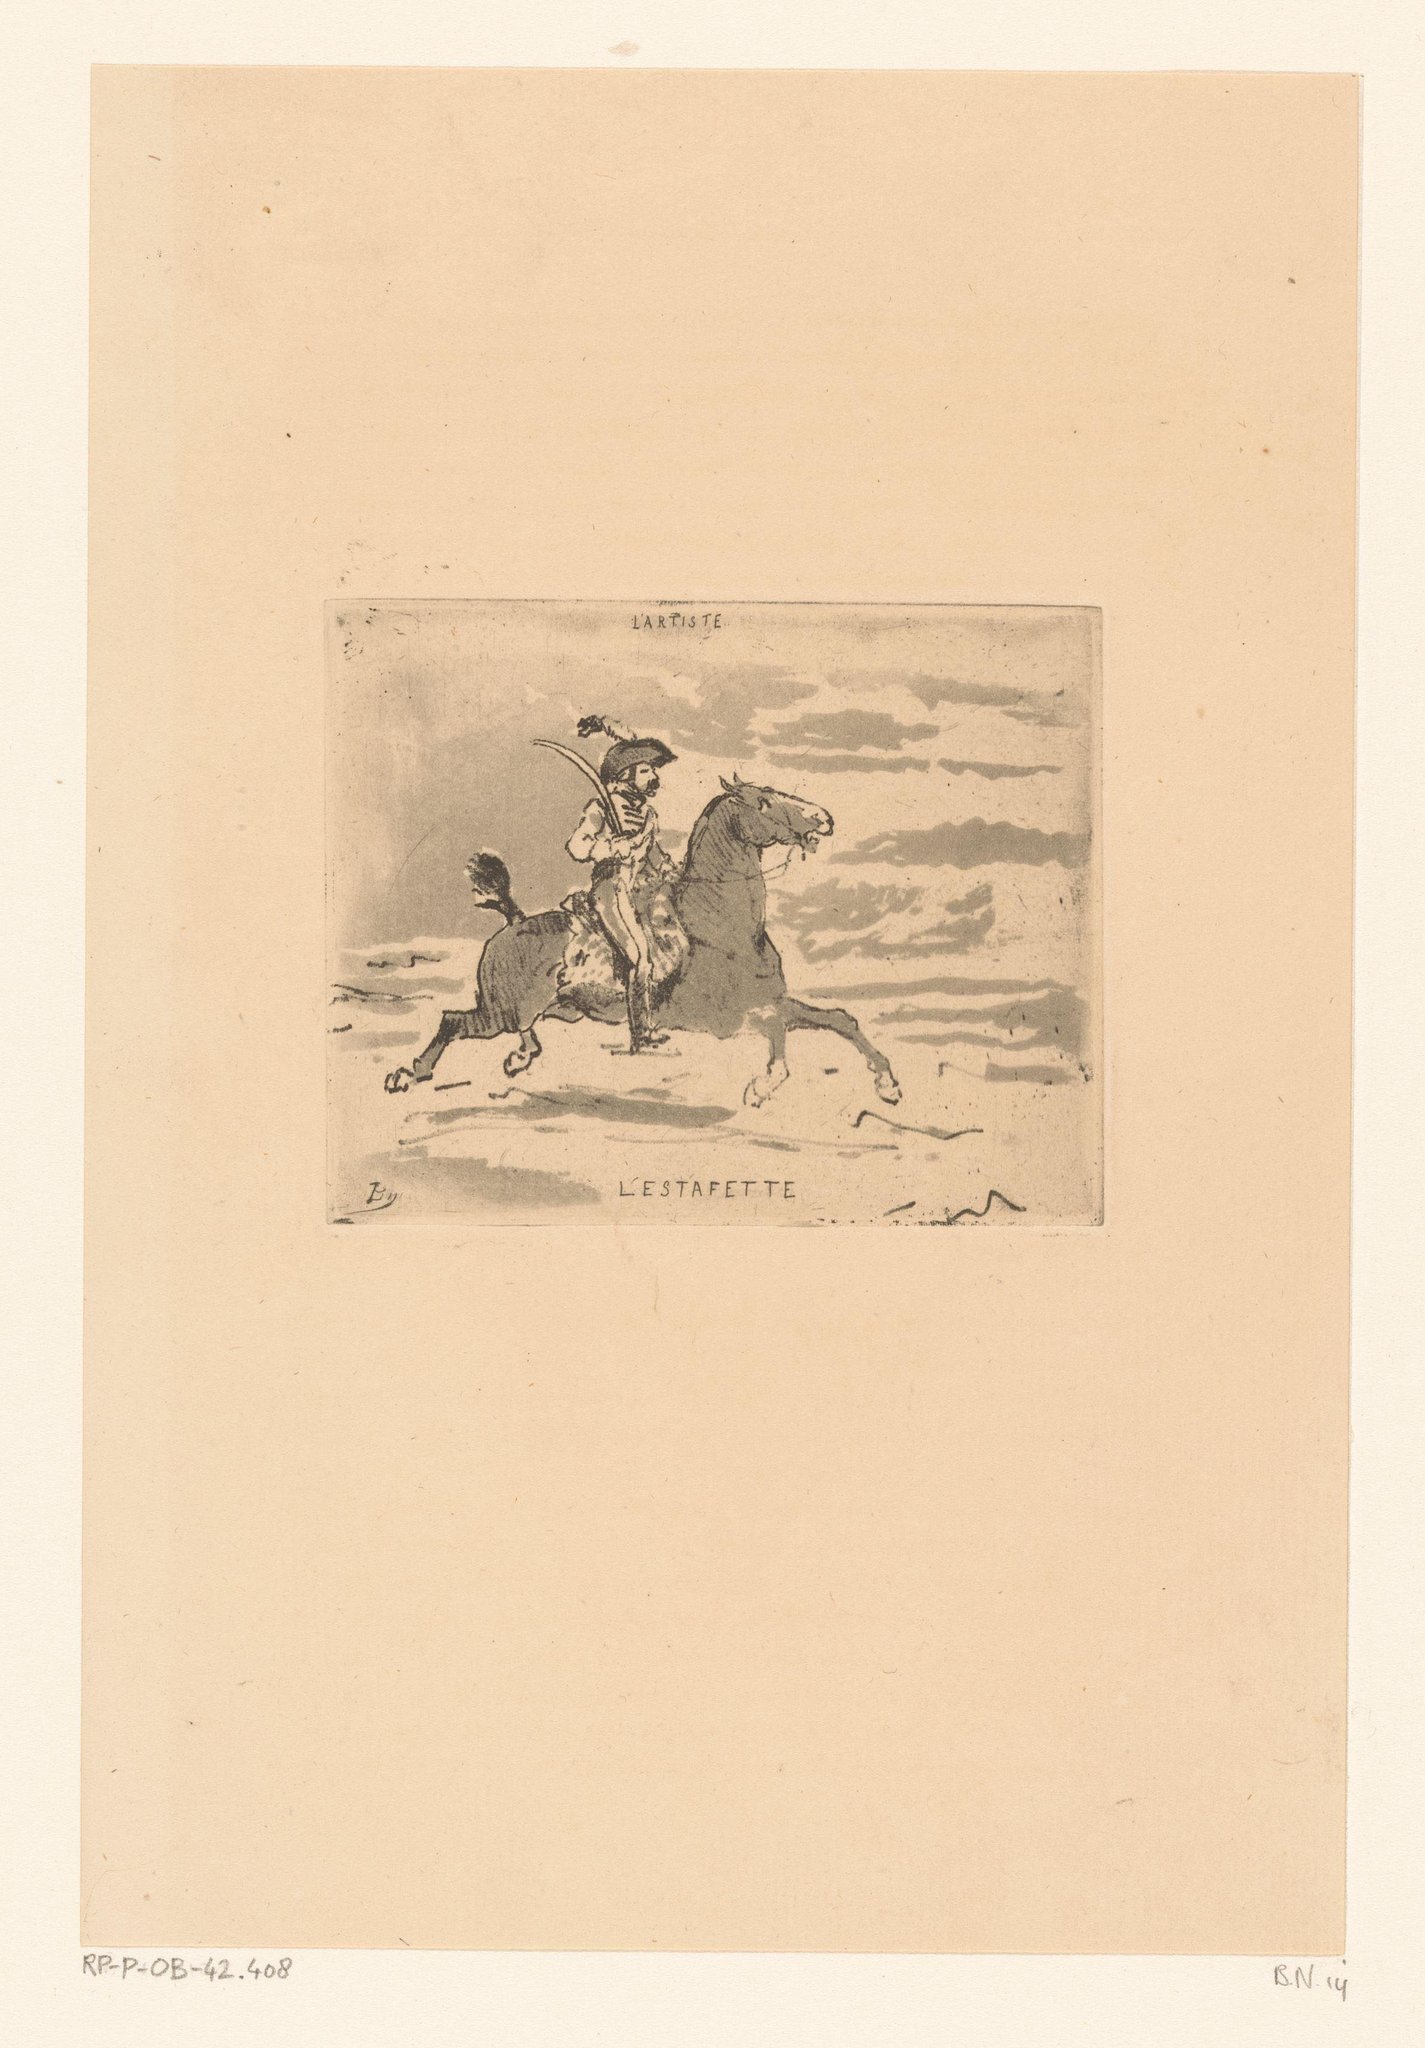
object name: print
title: Huzaar te paard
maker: john lewis brown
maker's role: print maker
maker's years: 1829-1890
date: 1887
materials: paper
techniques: etching, soft ground etching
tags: riding a horse, ass, or mule; rider, horseman, private soldier, horse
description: Gepubliceerd in 'l'Artiste' in 1889, p. 108.